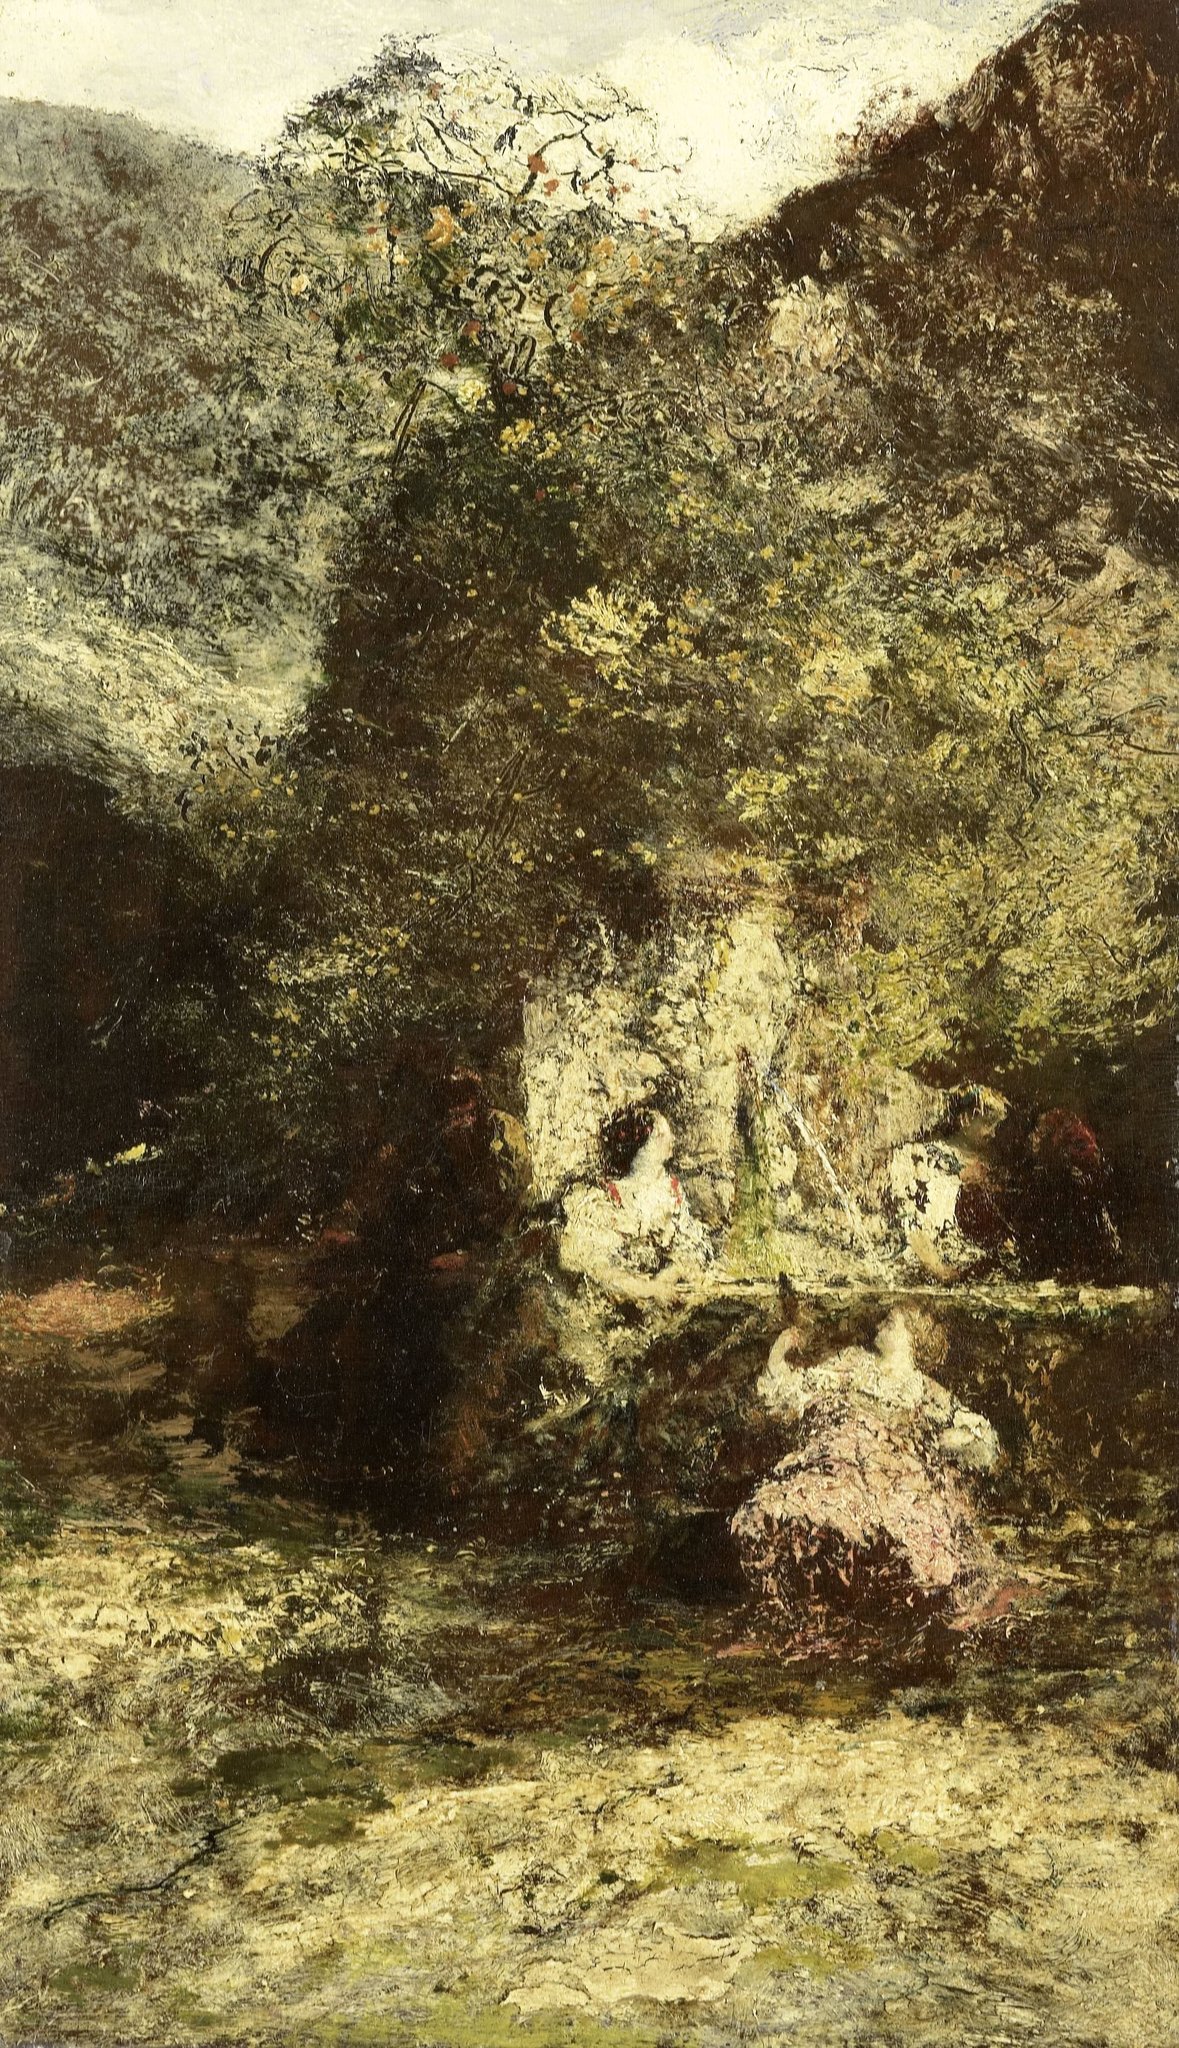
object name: painting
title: Figures near a Fountain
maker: adolphe joseph thomas monticelli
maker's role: painter, print maker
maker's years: 1824-1886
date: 1870-1886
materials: oil, panel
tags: spring, source of river or stream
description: Enkele vrouwen bij een fontein of bron aan de voet van een heuvel.